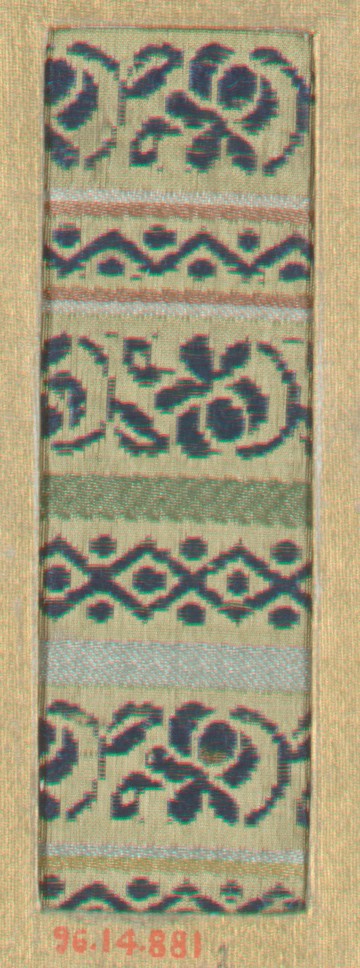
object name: piece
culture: japanese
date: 1701-1900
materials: silk